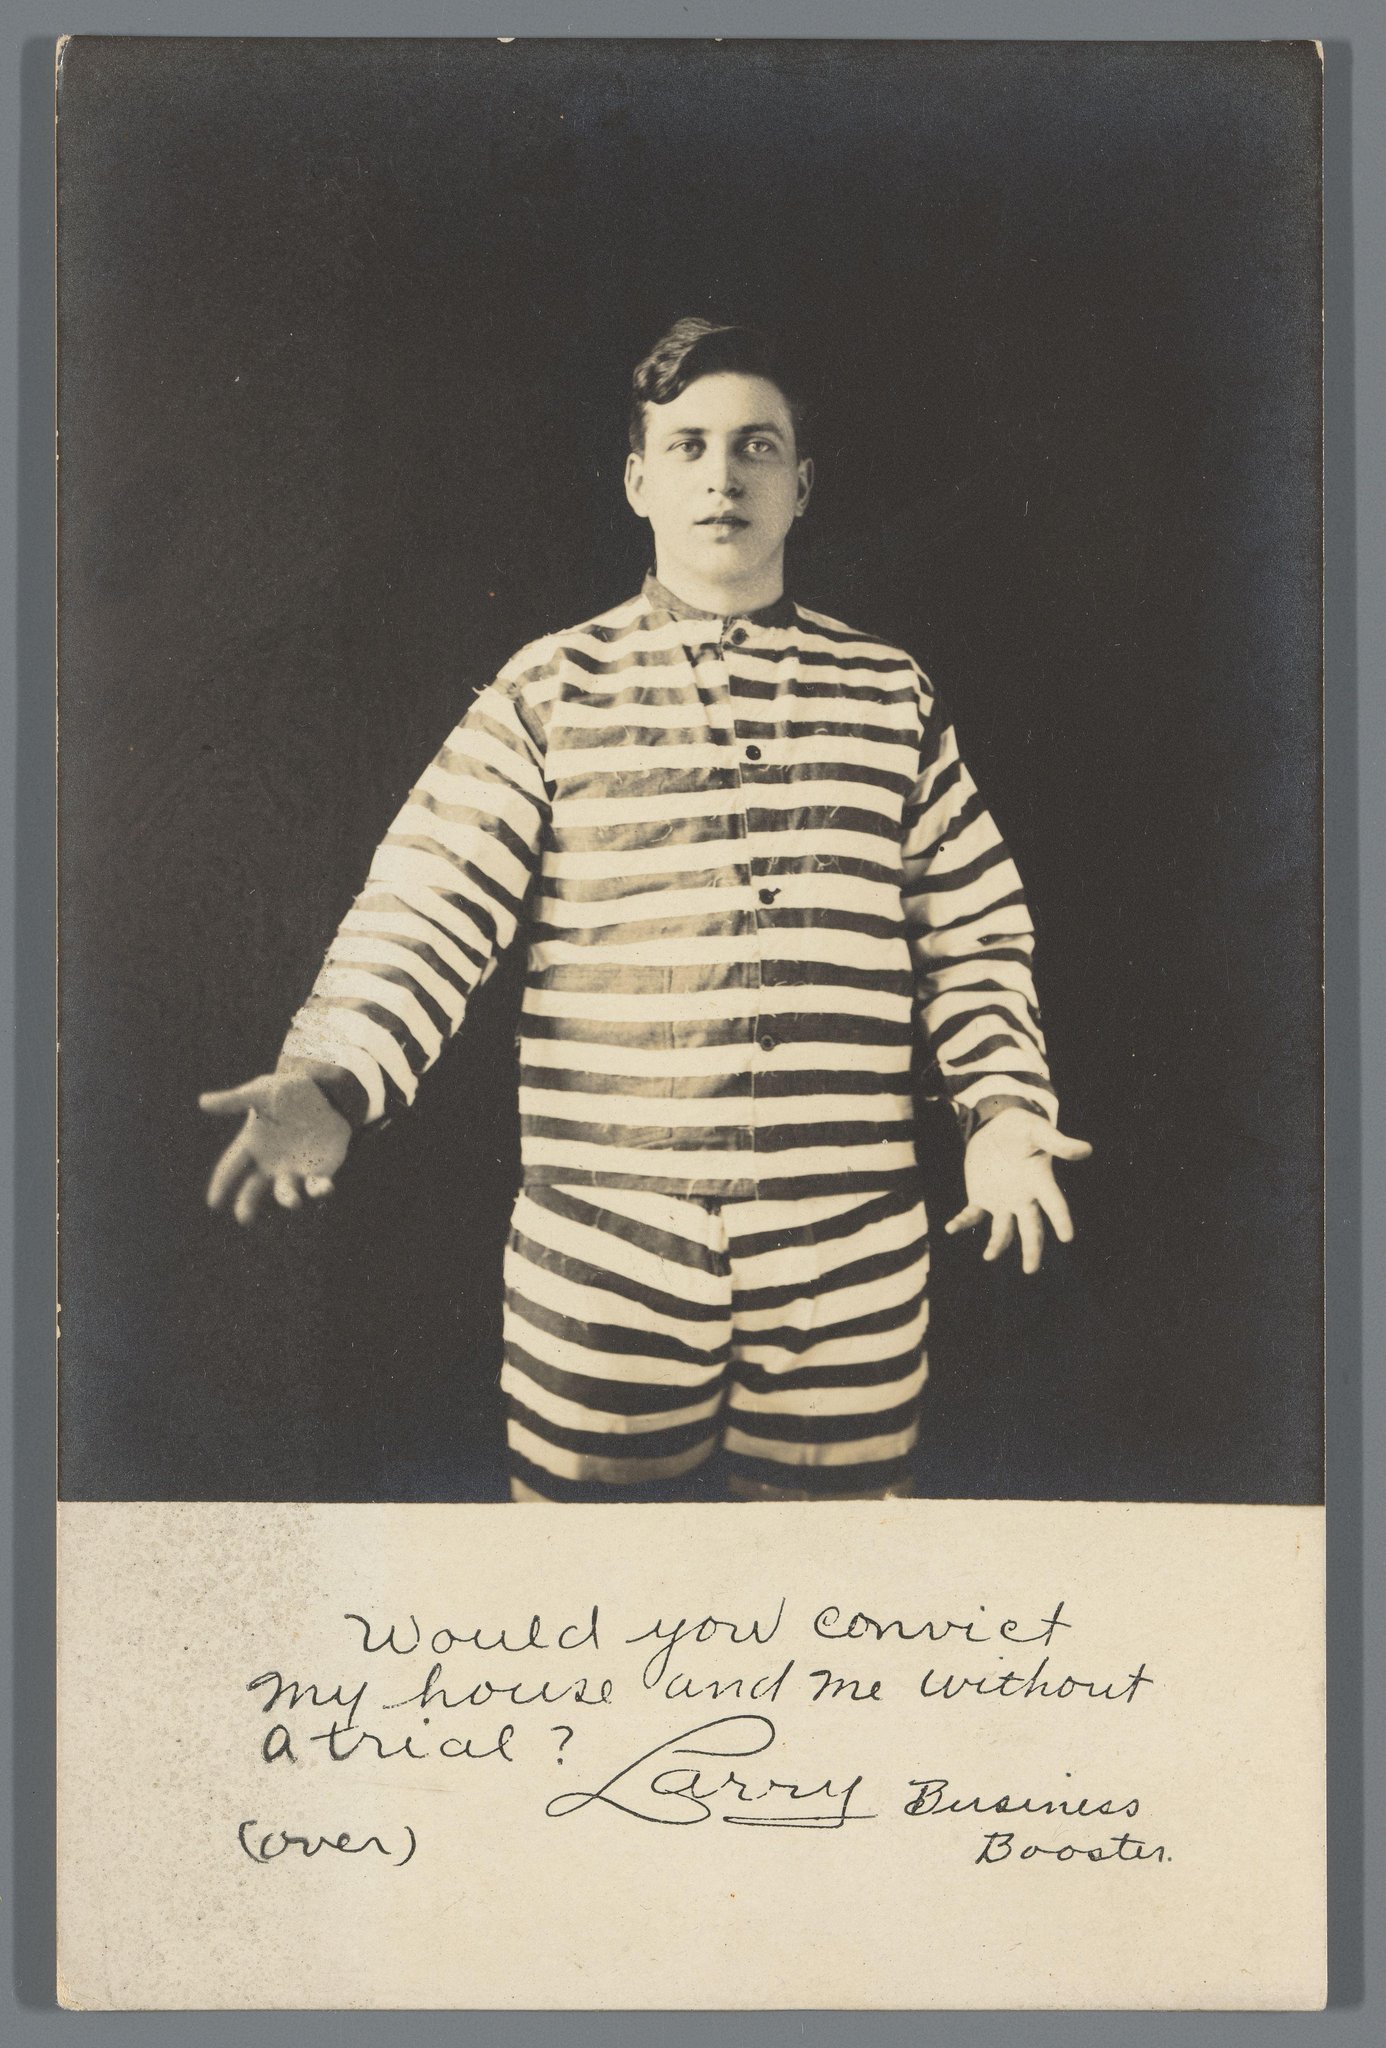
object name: ansichtkaart, prentbriefkaart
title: Reclame voor Kahn Bros, Louisville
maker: Anonymous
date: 1930-1950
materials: photographic support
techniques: gelatin silver print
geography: united states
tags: kahn bros, louisville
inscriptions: inscription, inscription